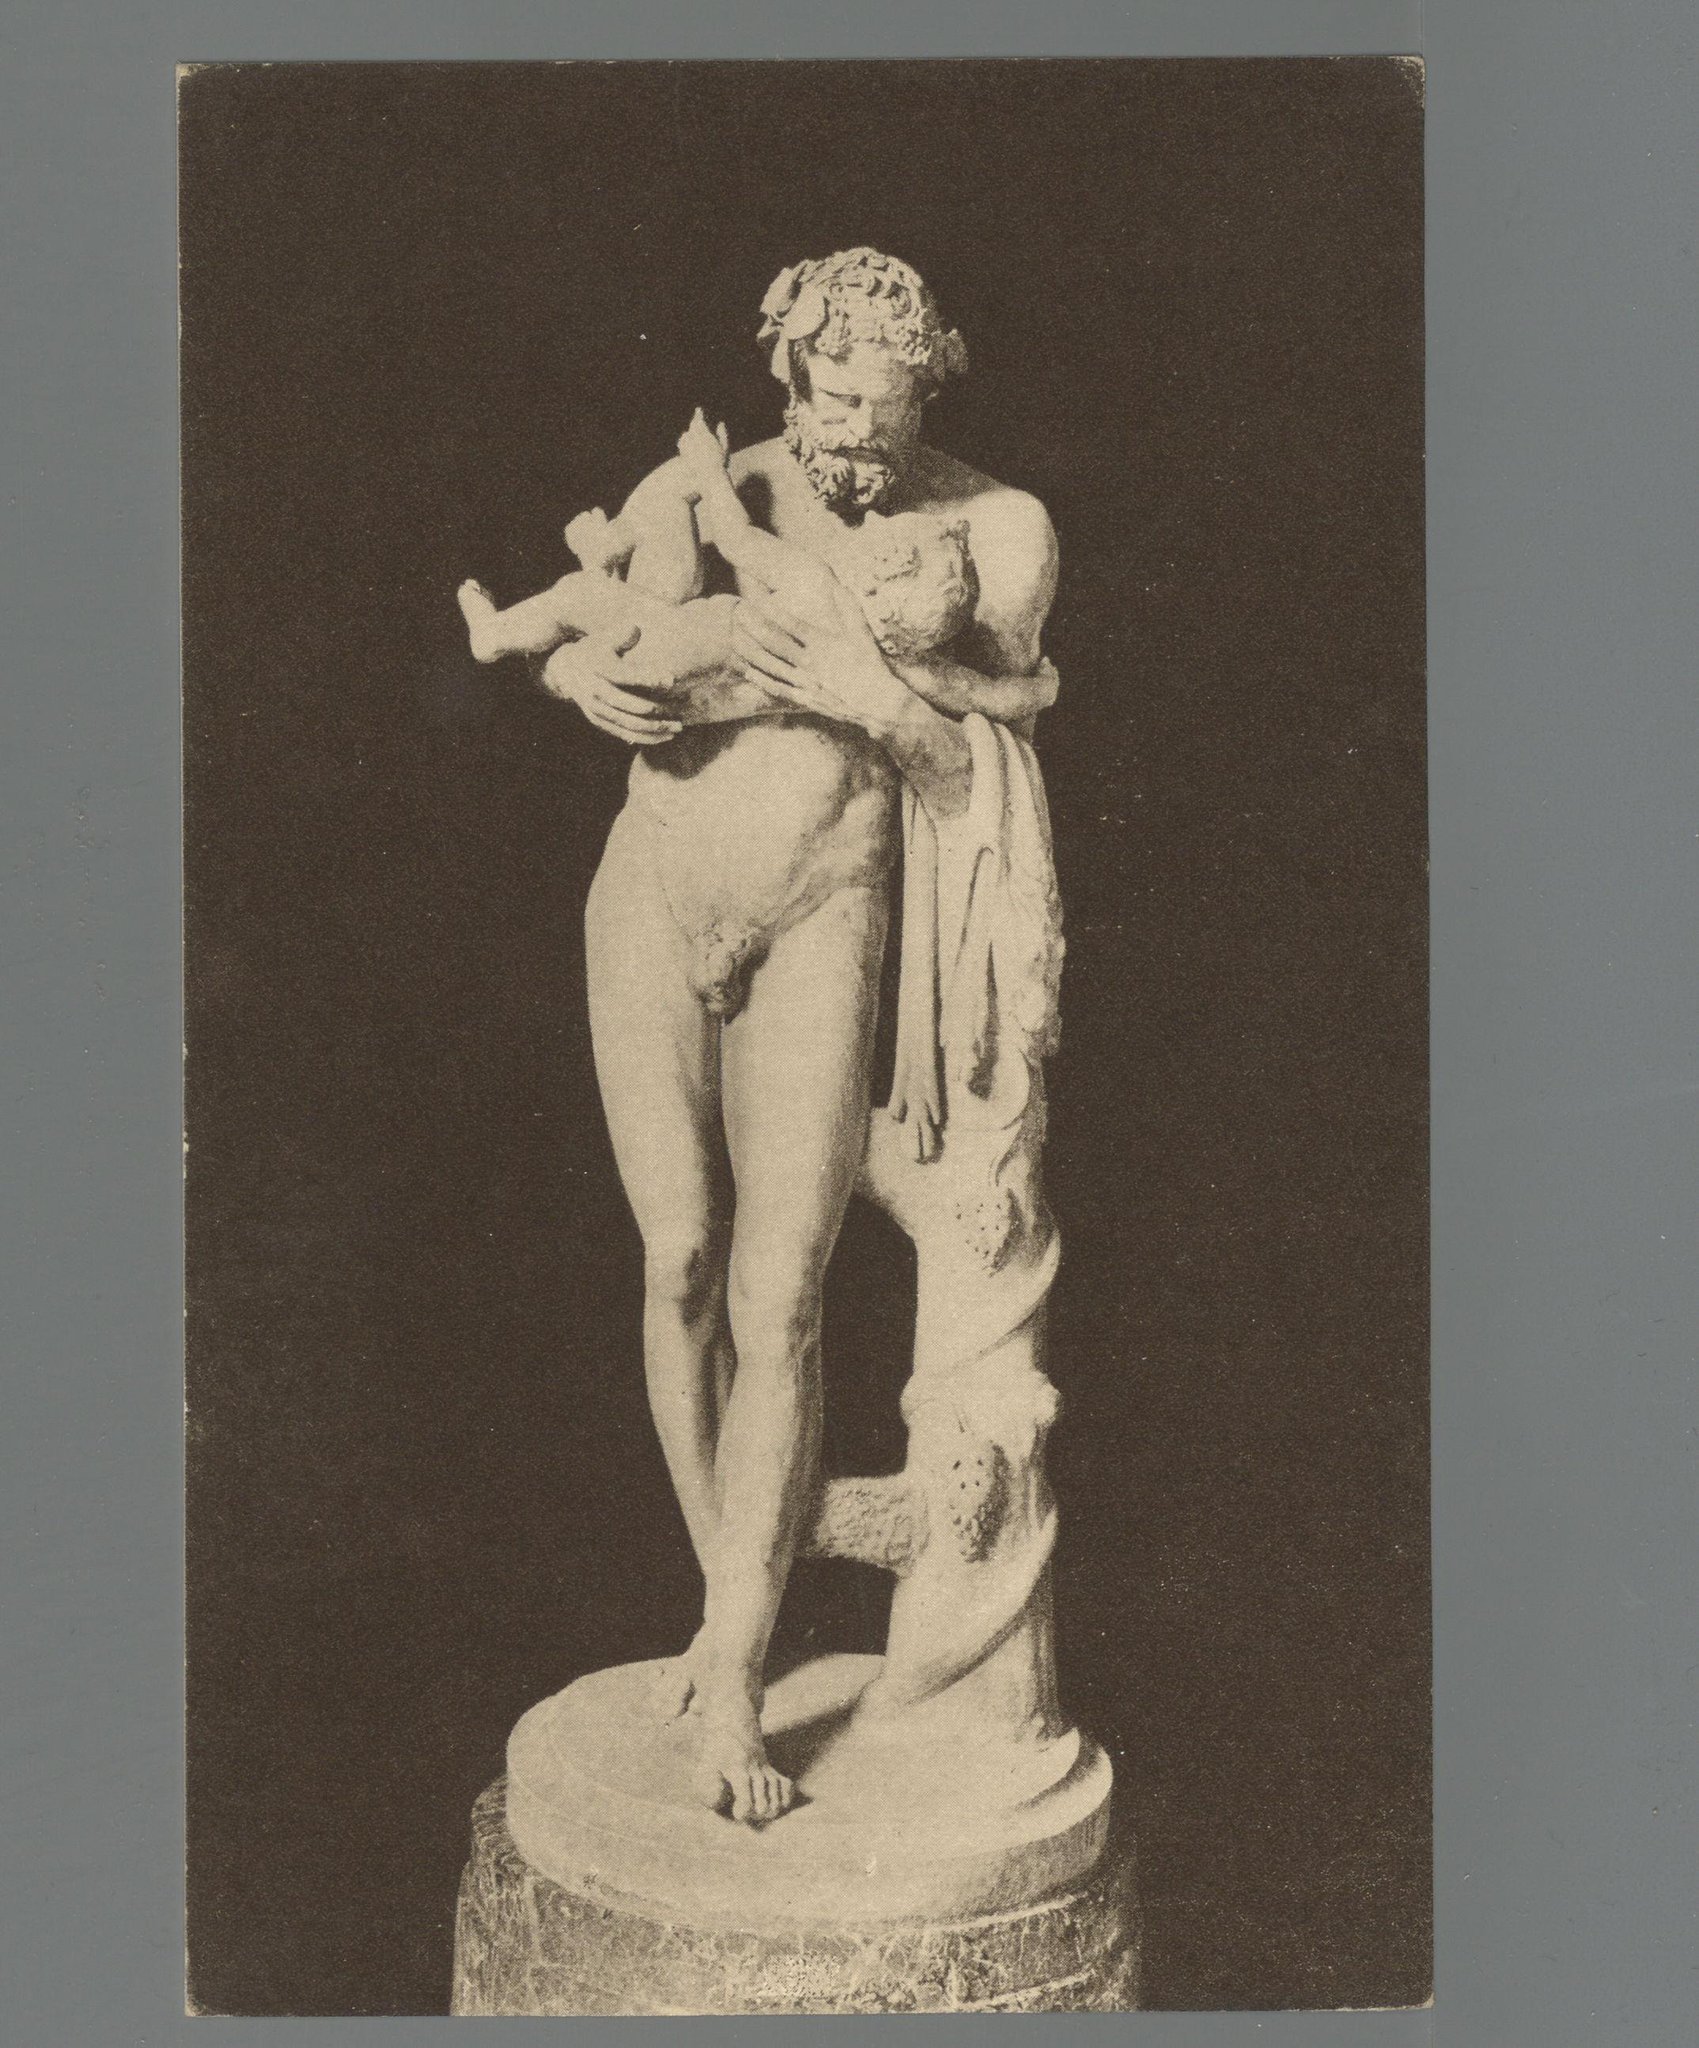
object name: photomechanical print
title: Silen und Dionysoskind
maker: Anonymous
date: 1905-1930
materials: cardboard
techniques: rotogravure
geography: munich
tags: monument, statue, permanent exhibition, museum